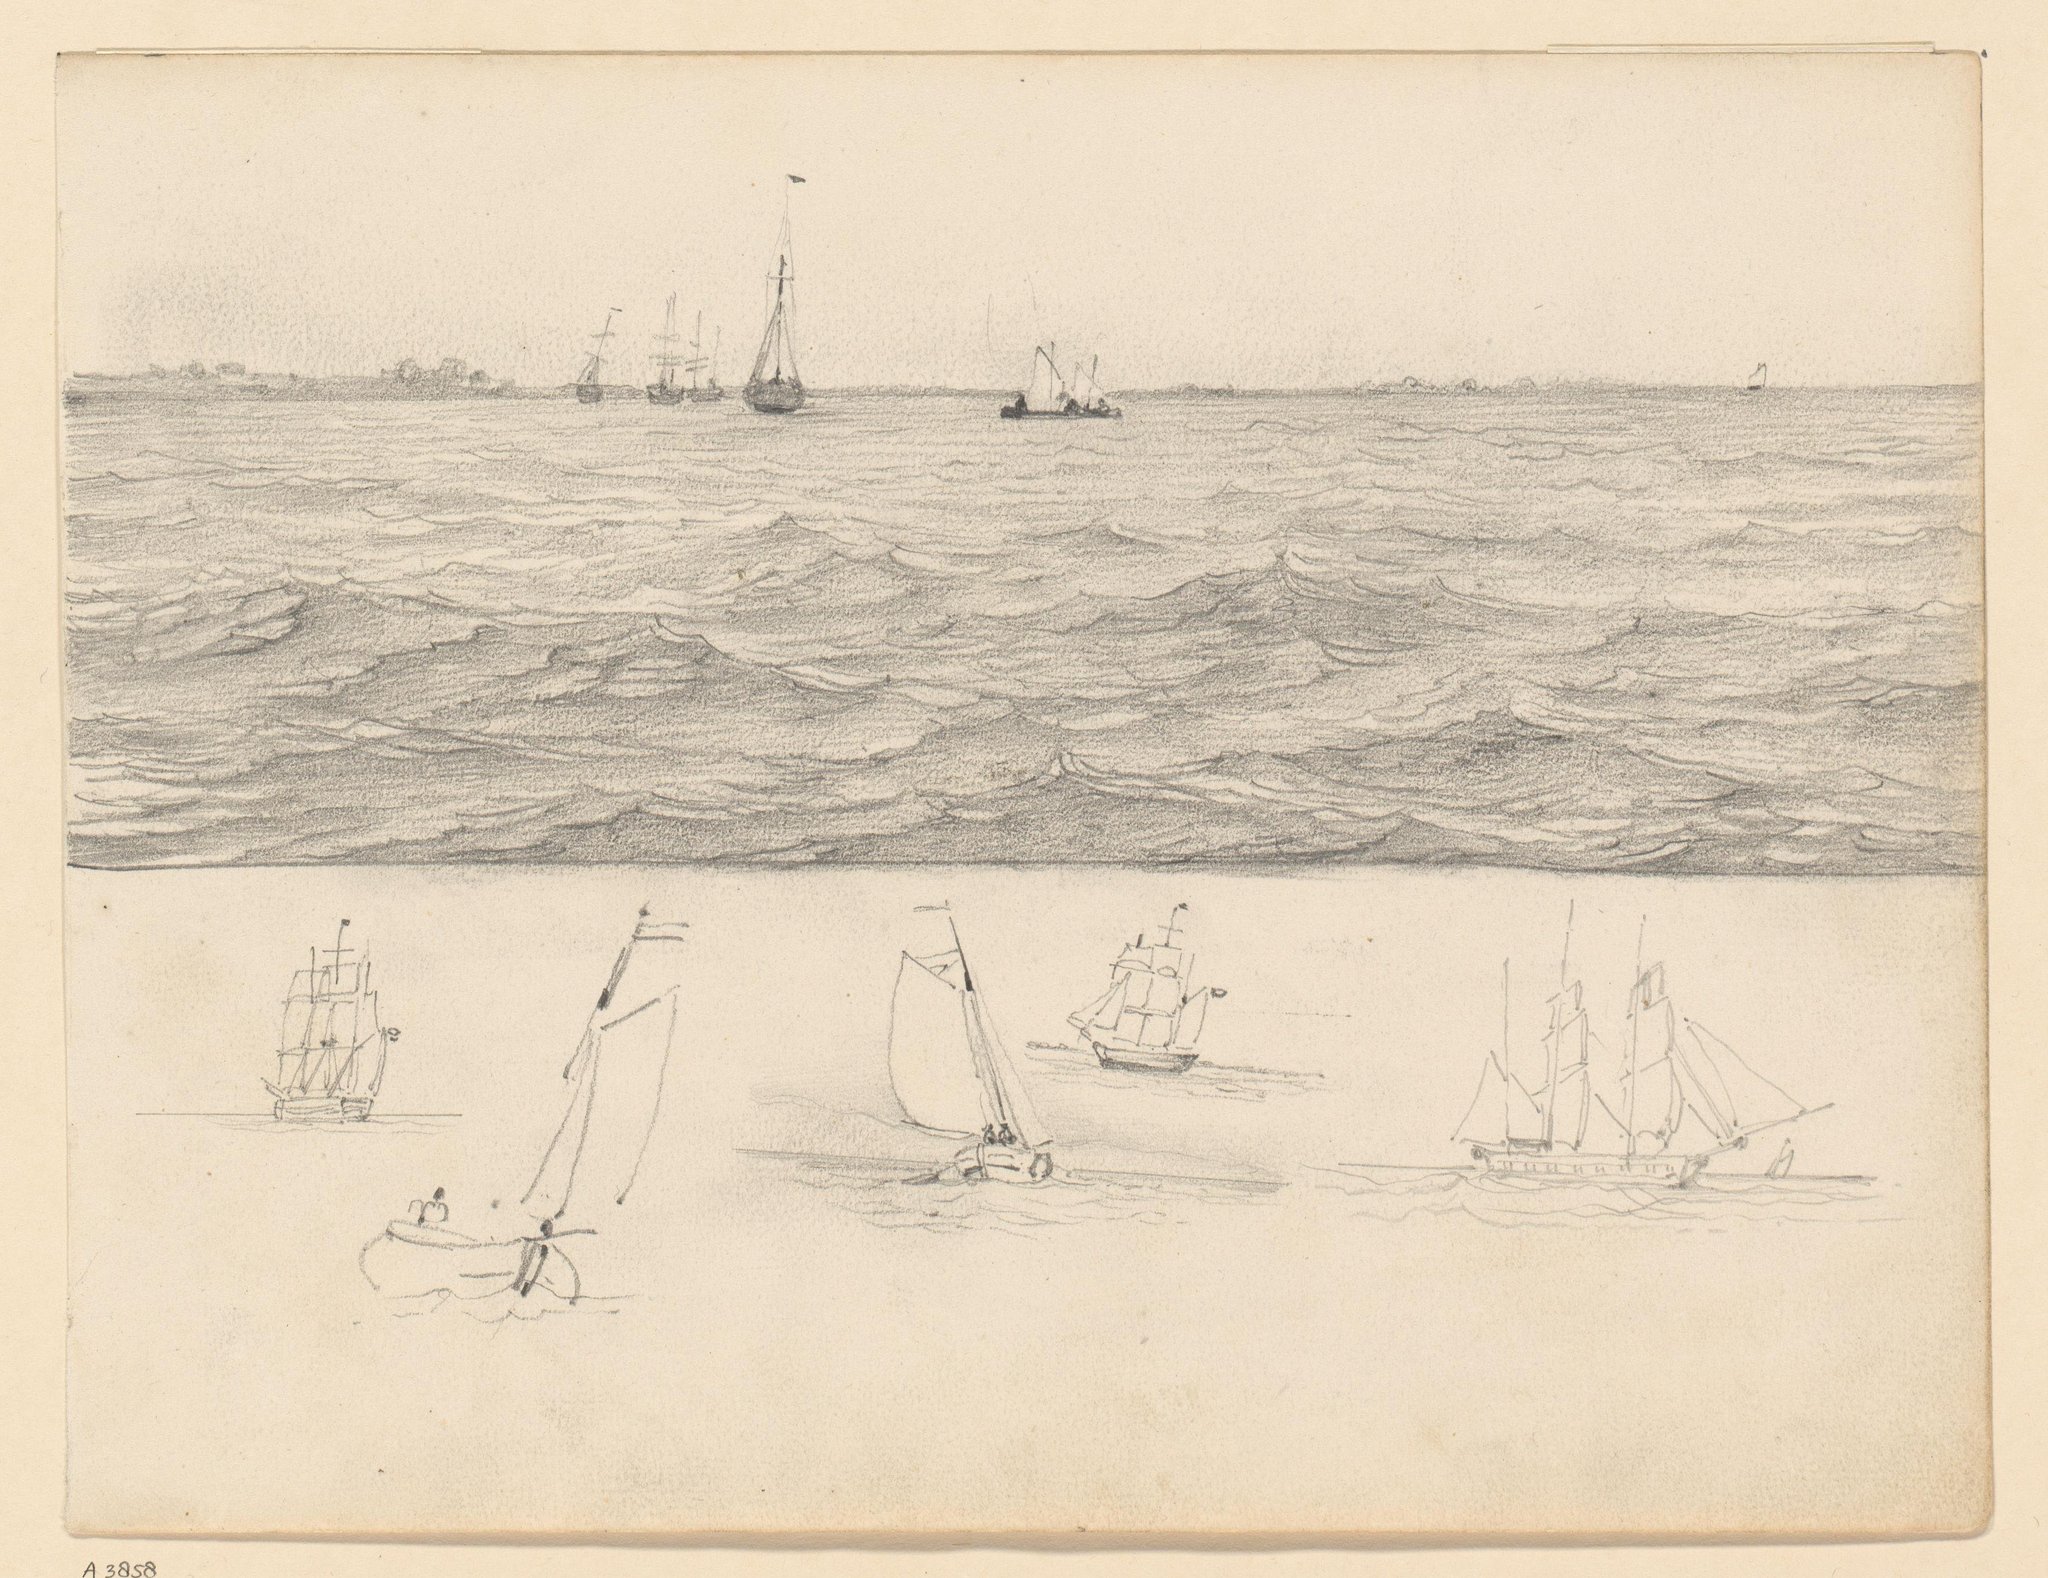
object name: drawing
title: Zeegezicht en studies van schepen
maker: willem anthonie van deventer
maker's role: draughtsman, painter, print maker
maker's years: 1824-1893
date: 1834-1893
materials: paper, pencil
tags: sailing-ship, sailing-boat, sea (seascape)